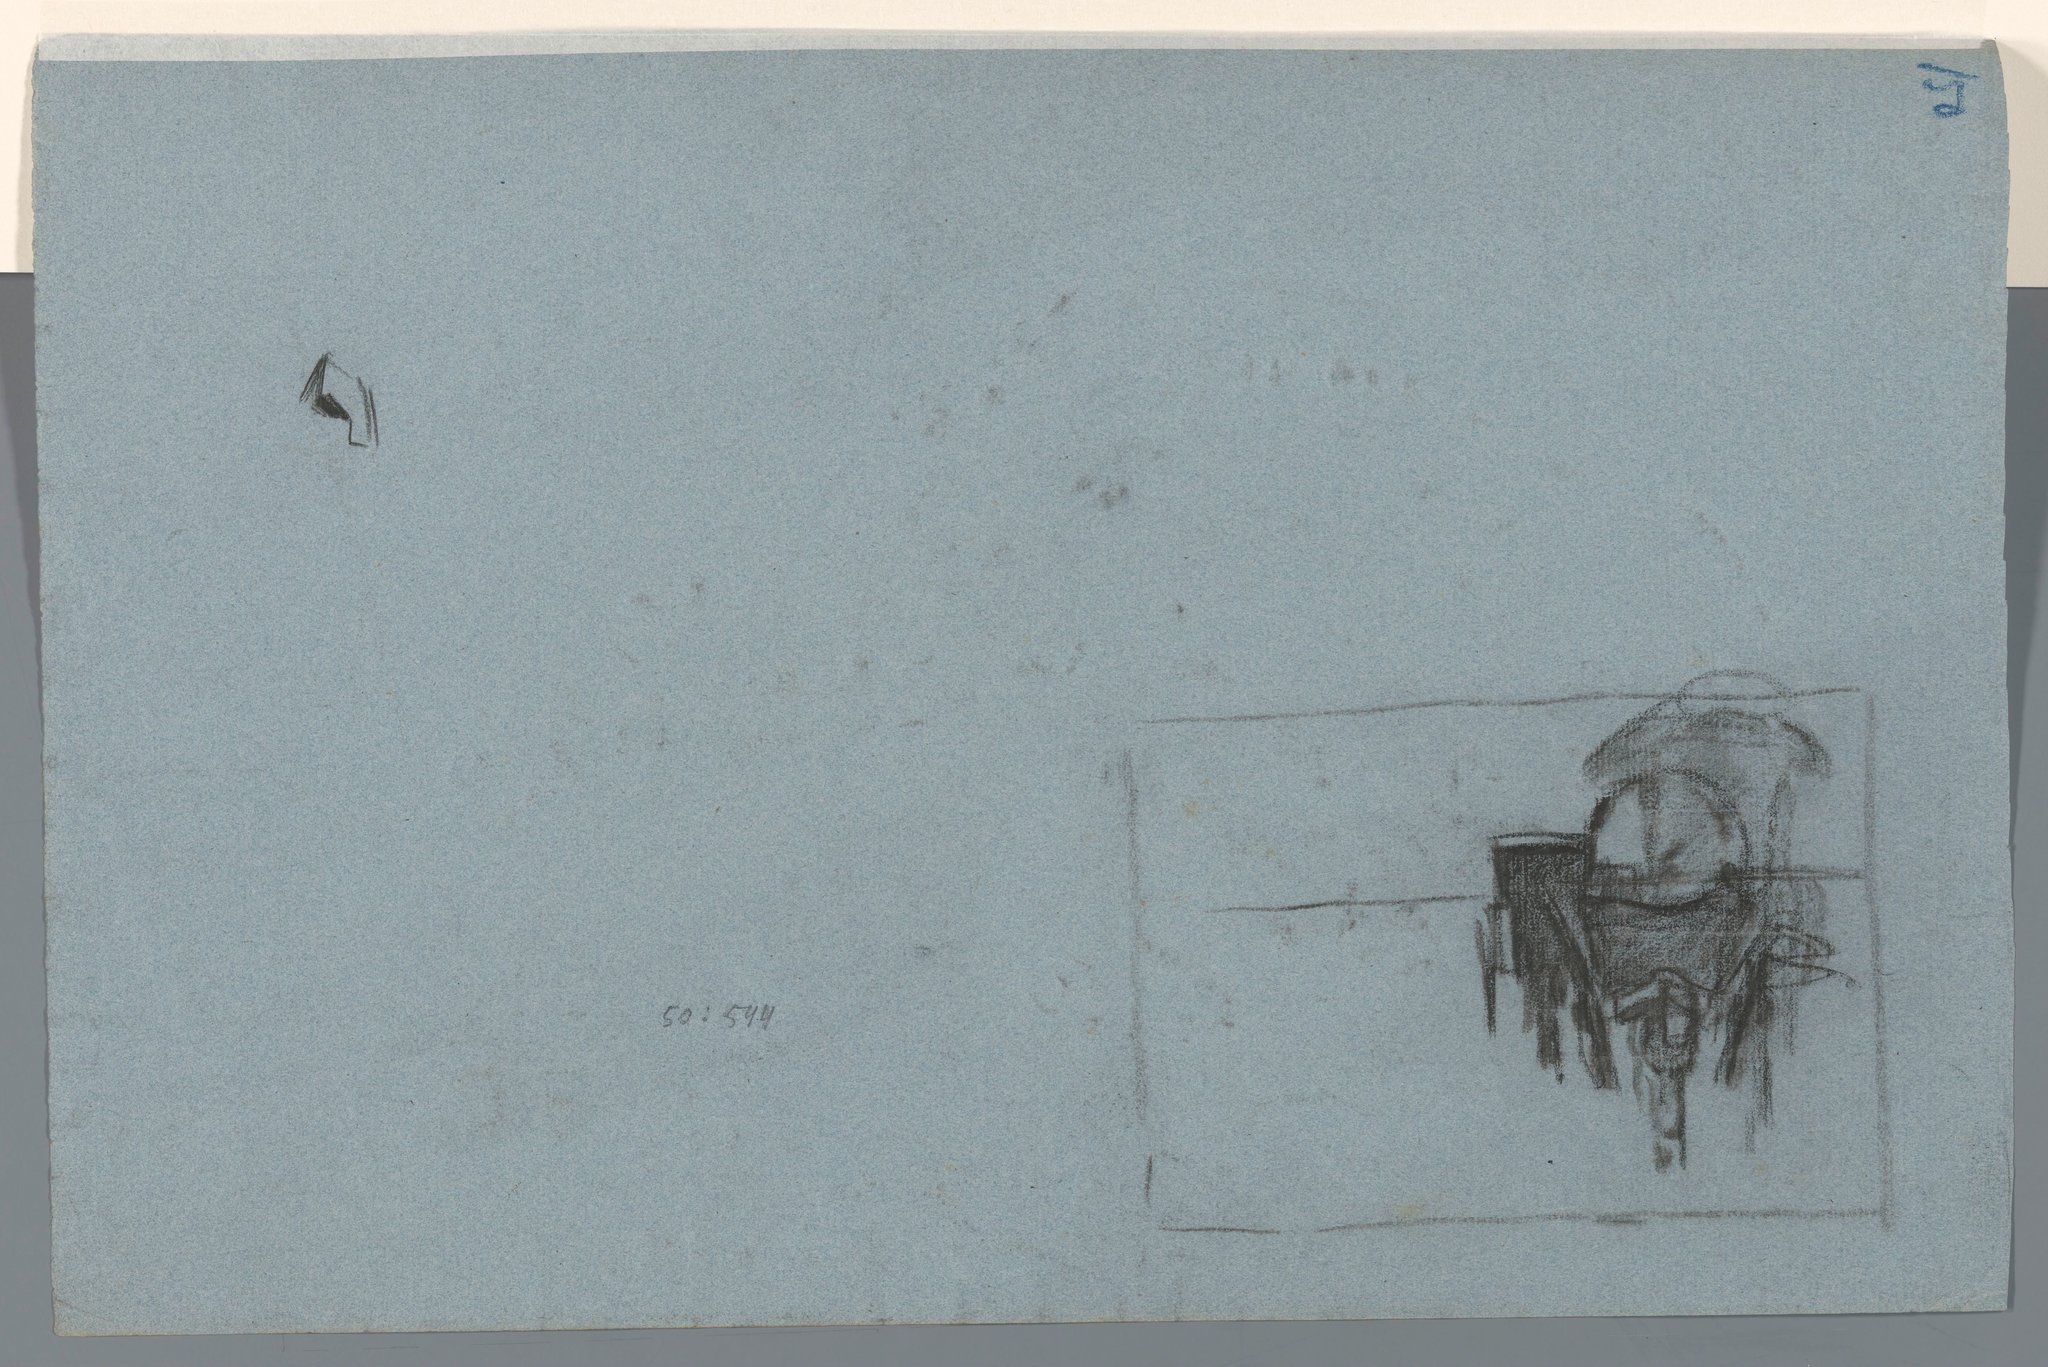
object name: drawing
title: Schets van een paard en wagen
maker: pieter de josselin de jong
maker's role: draughtsman, painter, print maker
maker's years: 1861-1906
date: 1871-1906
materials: chalk, paper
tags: (farm) wagon, freight wagon, cart